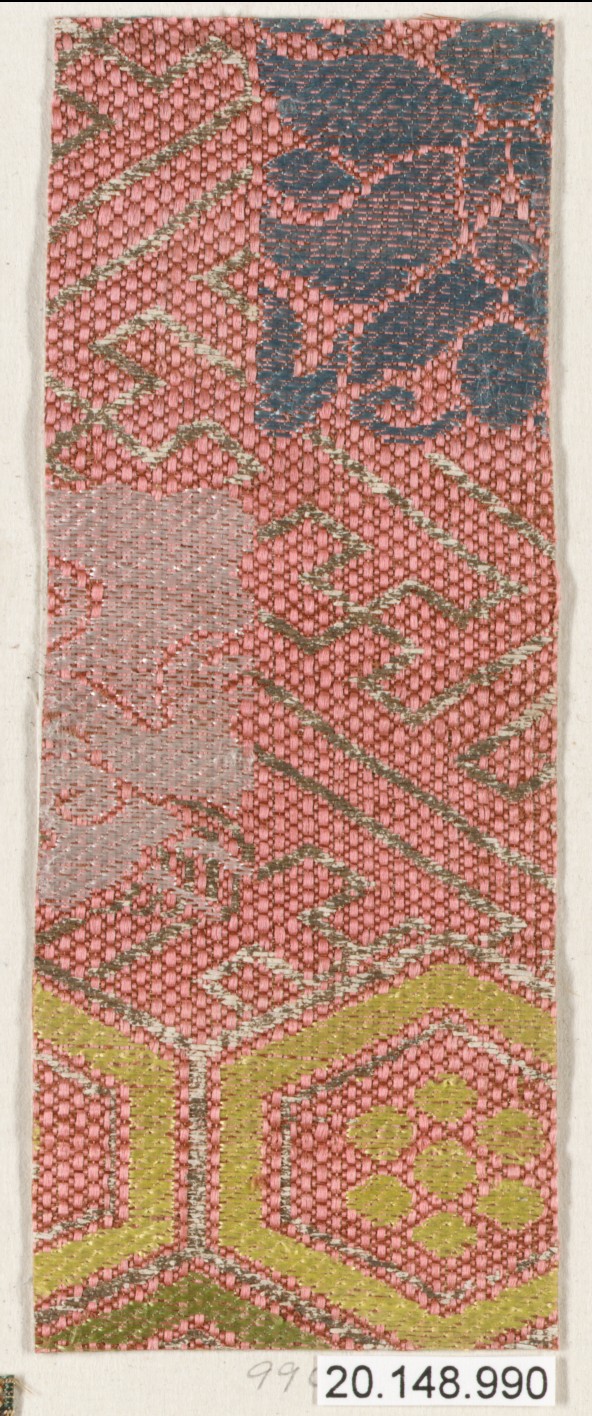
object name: piece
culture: japanese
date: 1601-1700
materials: silk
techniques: compound weave